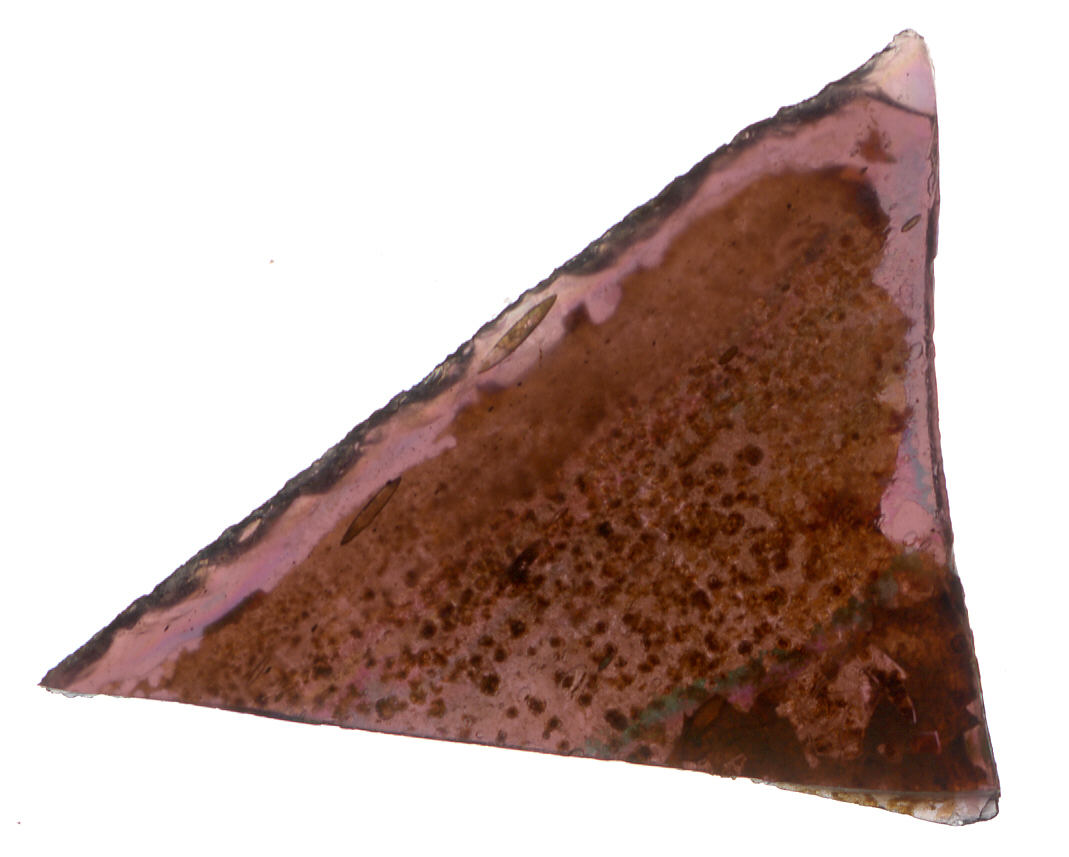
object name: fragment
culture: crusader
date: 1201-1300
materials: glass